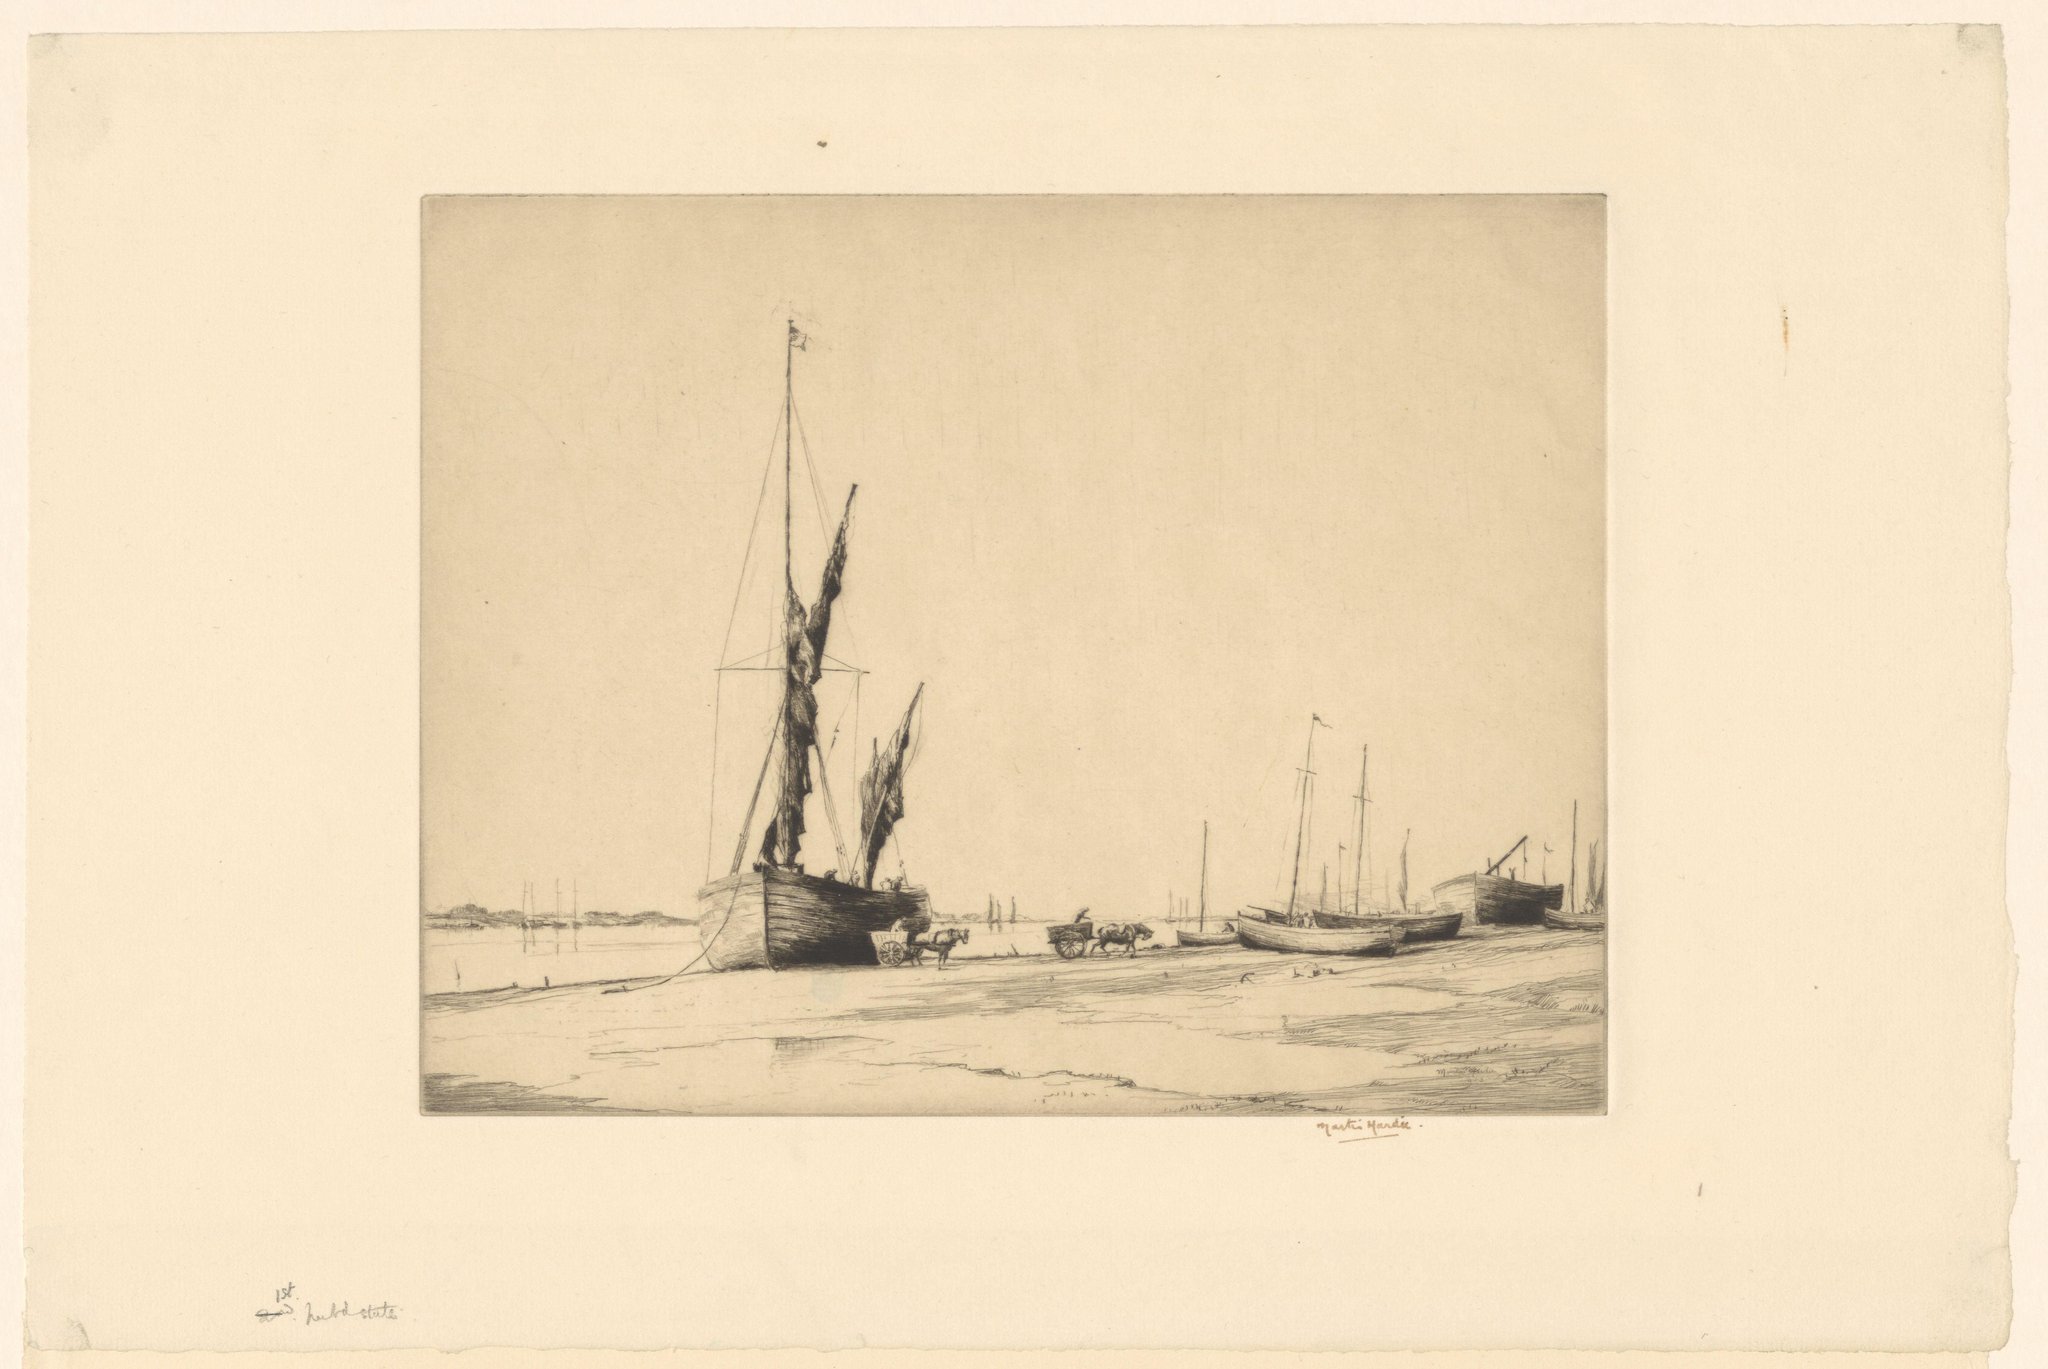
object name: print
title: Vissersboten worden uitgeladen in West Mersea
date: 1923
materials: paper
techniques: drypoint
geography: west mersea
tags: harbouring, (farm) wagon, freight wagon, cart, coast (+ landscape with figures, staffage)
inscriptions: collector's mark: Lugt 2228, annotation: ‘Martin Hardie’, collector's mark: Lugt 2760